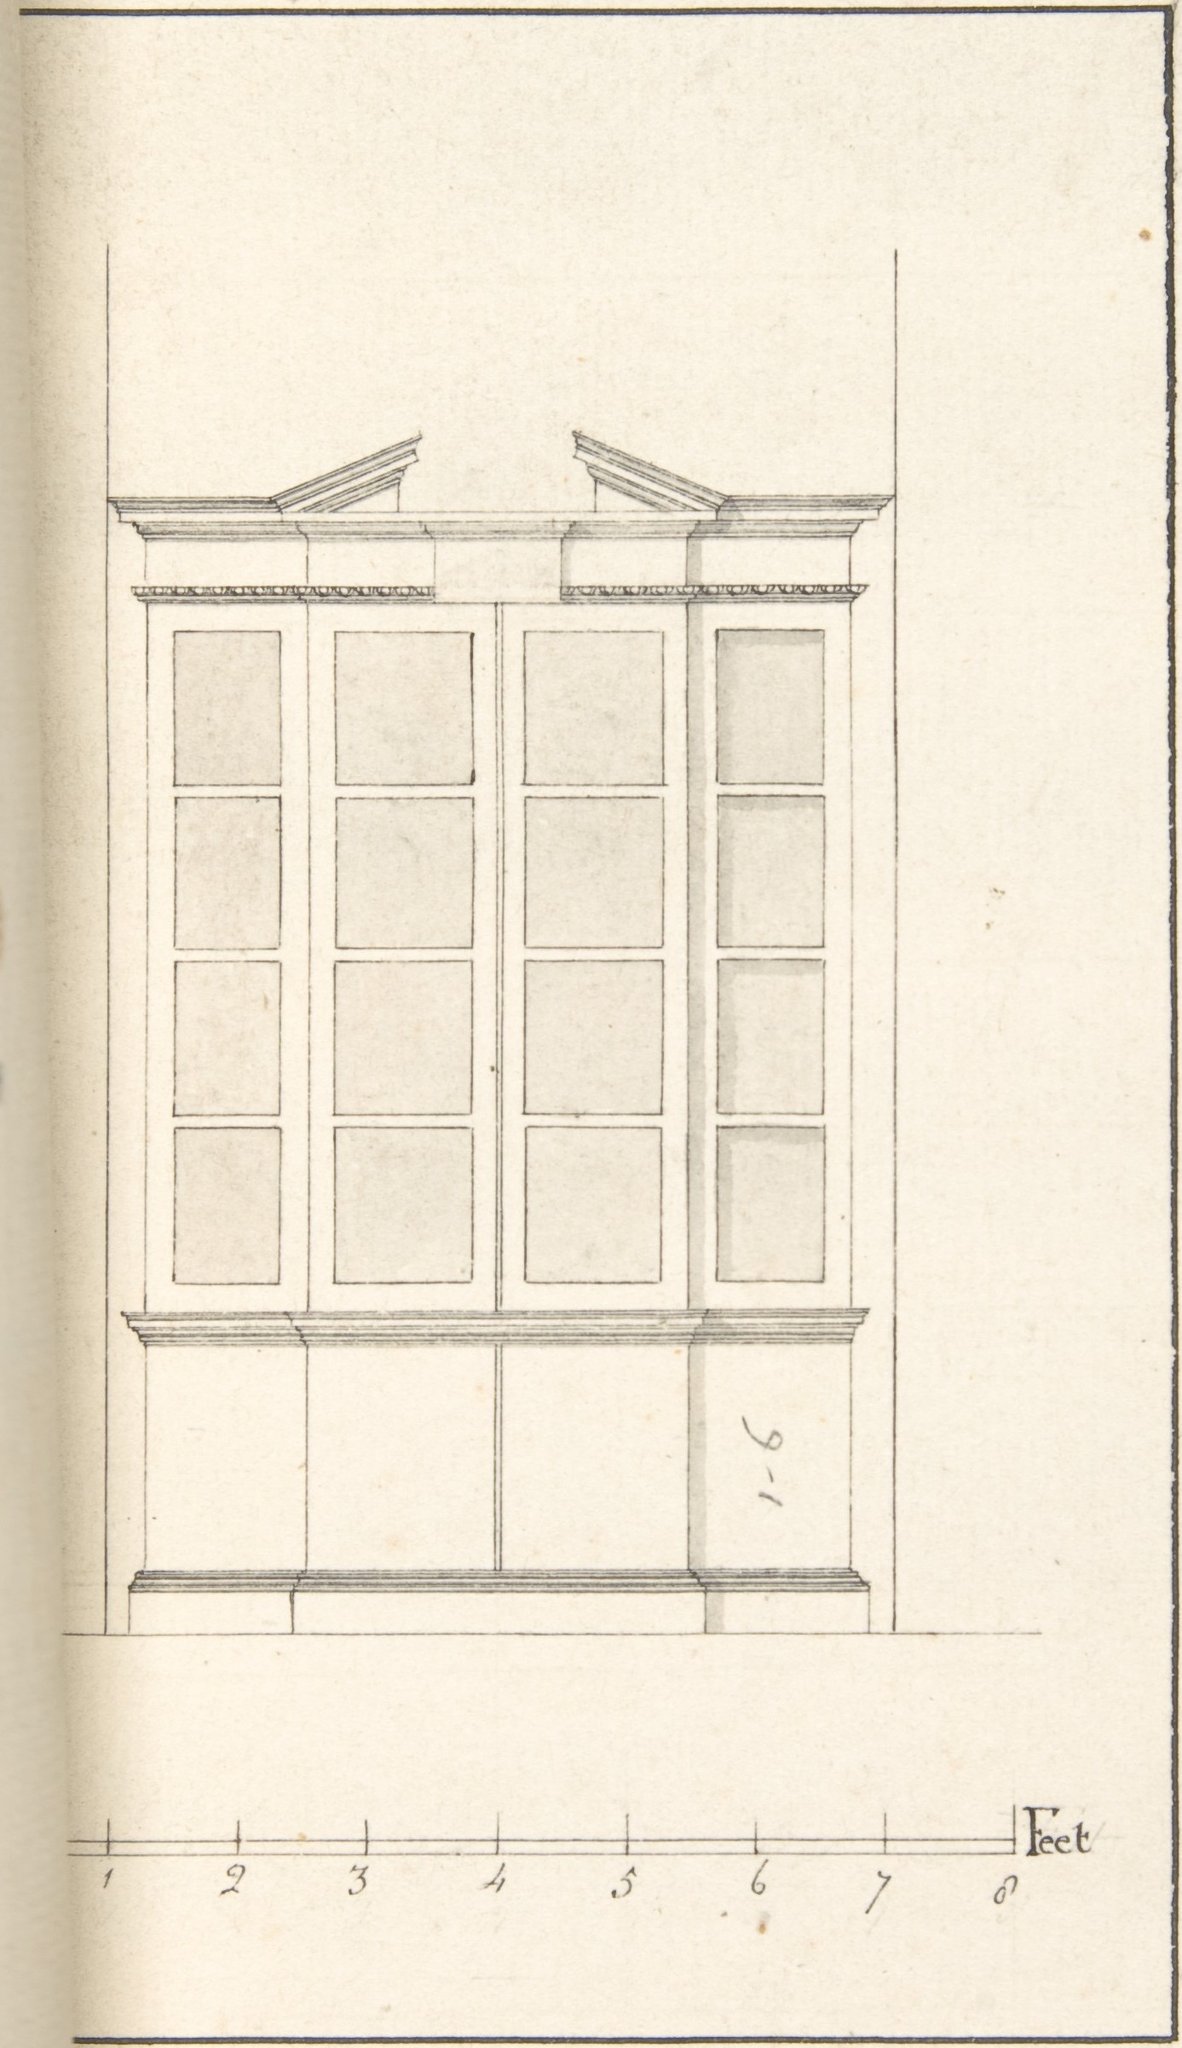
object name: drawing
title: Breakfront Bookcase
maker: robert morris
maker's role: artist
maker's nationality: british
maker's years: 1701-1754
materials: ink, watercolor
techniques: brush, pen, wash